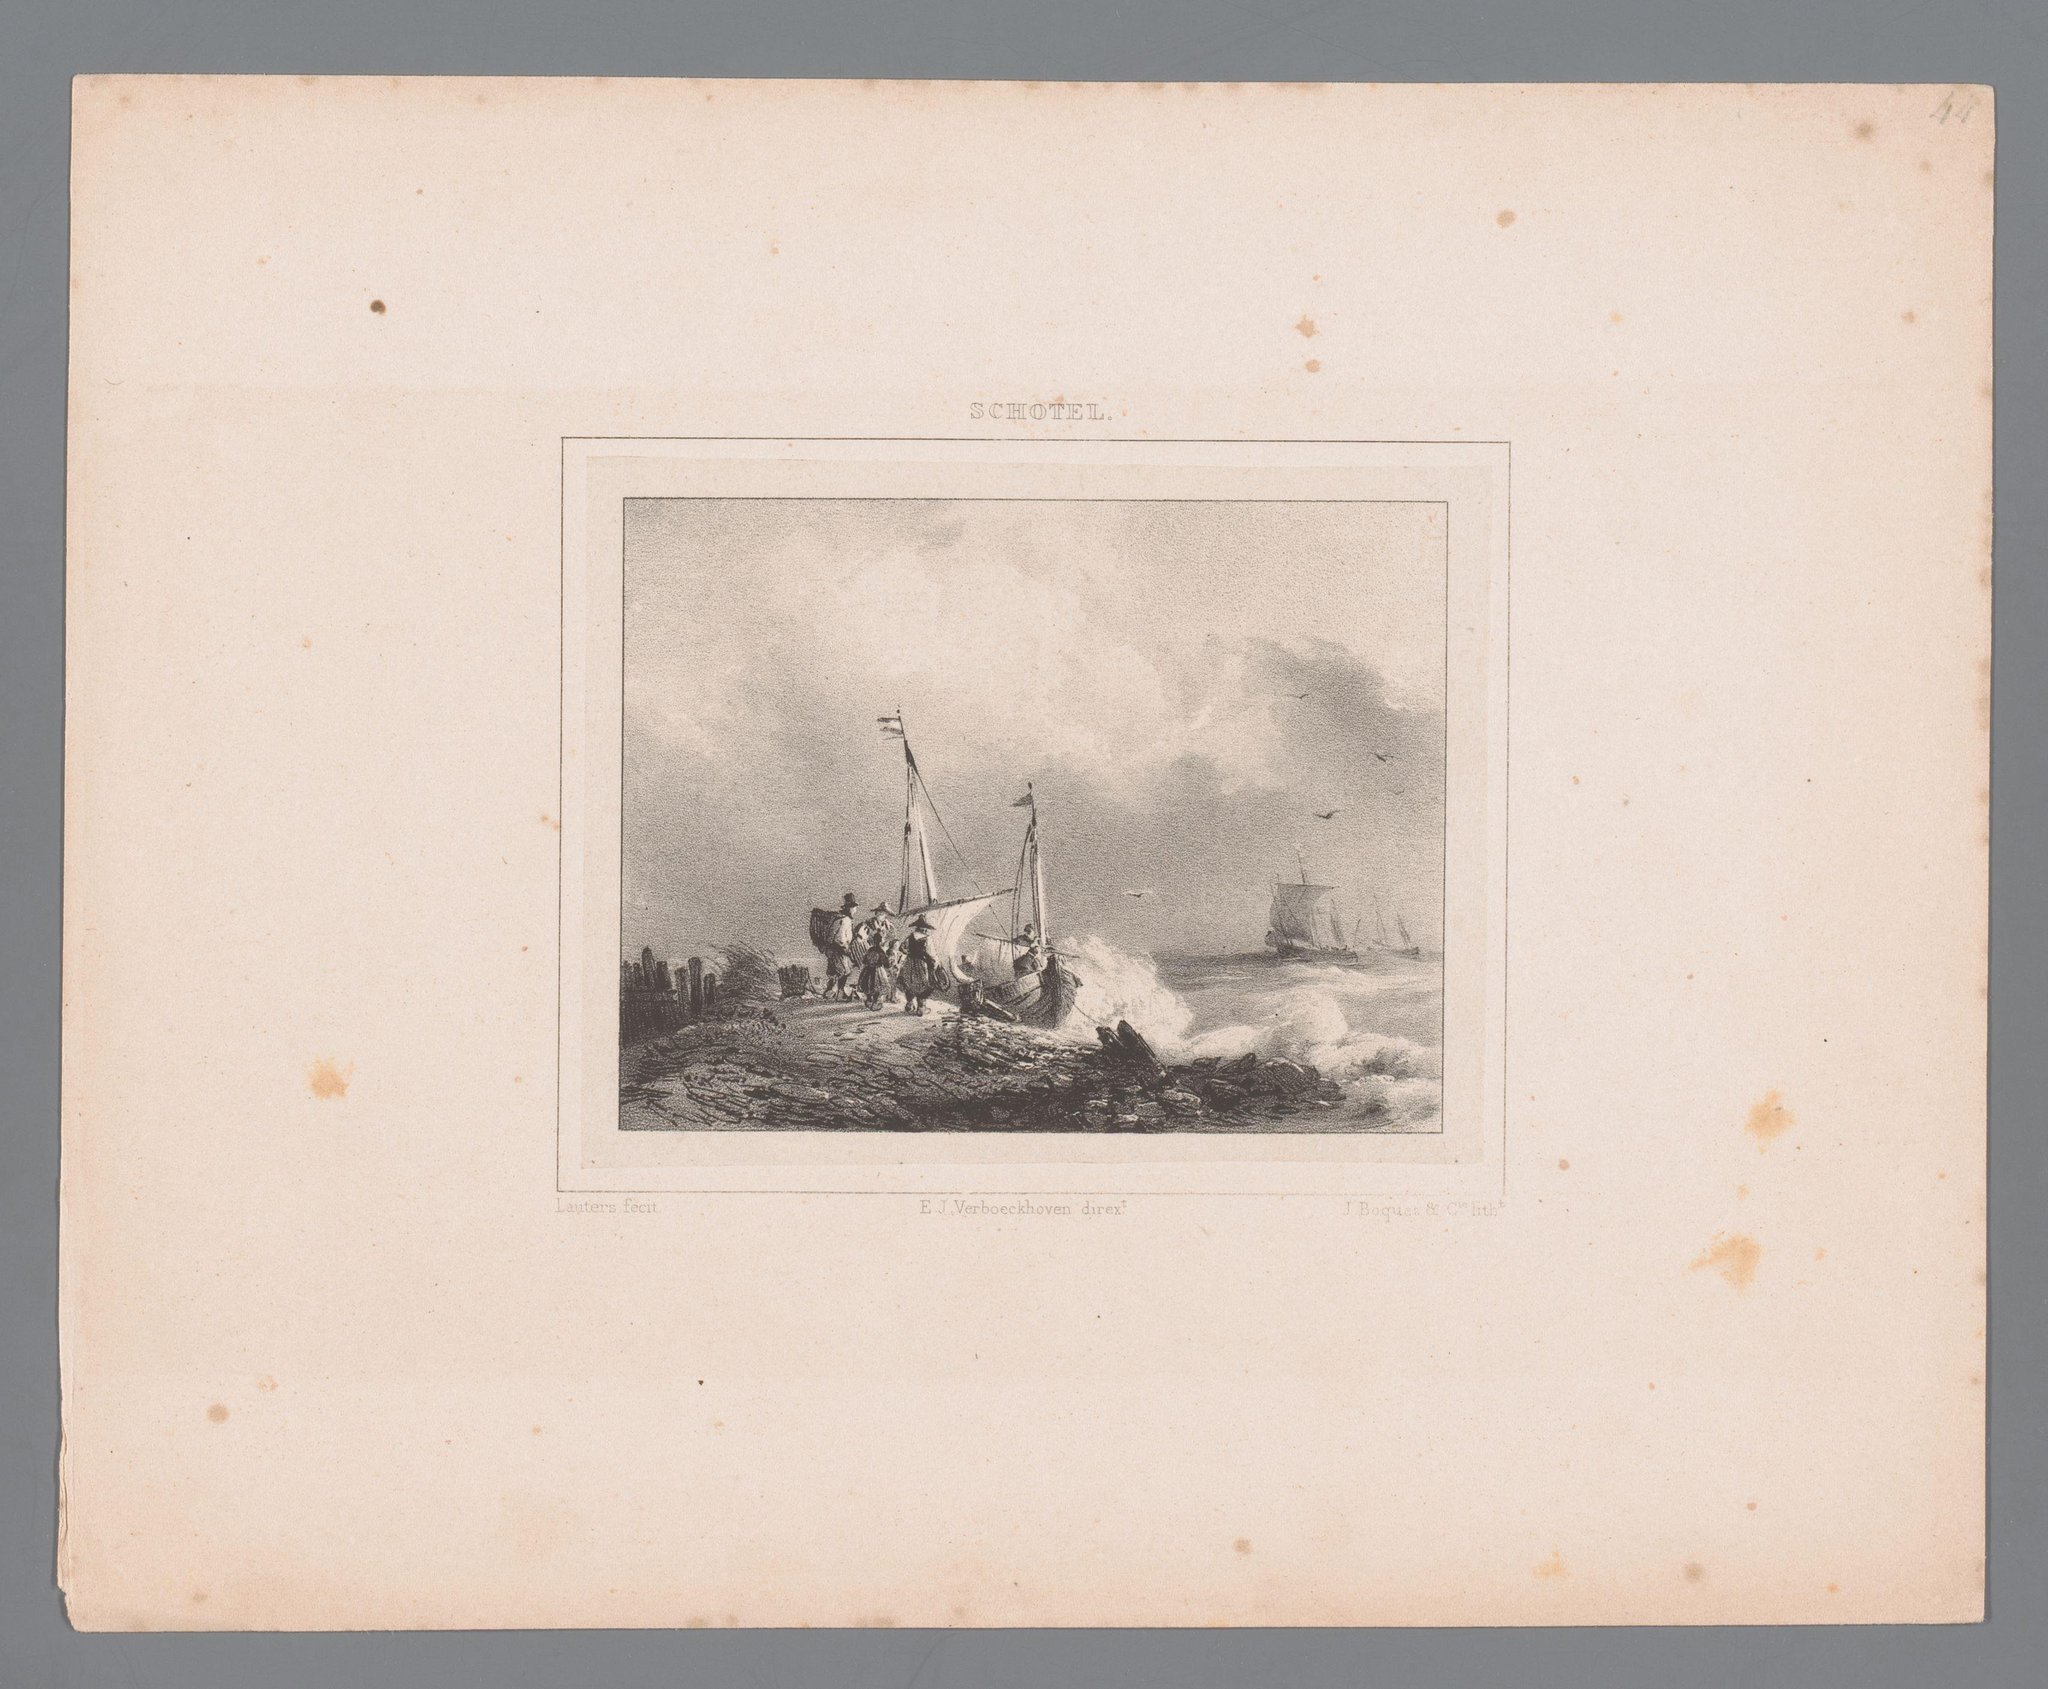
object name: print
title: Schotel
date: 1829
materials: paper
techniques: lithograph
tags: ships (in general) - cc - more than one ship, coast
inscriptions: collector's mark: Lugt 2233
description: Prent verschenen in: Verboeckhoven, Eugène. Album lithographié par Paul Lauters d'après les dessins des principaux peintres du Royaume des Pays-Bas. Brussel: Antoine Dewasme-Pletinckx, 1829.